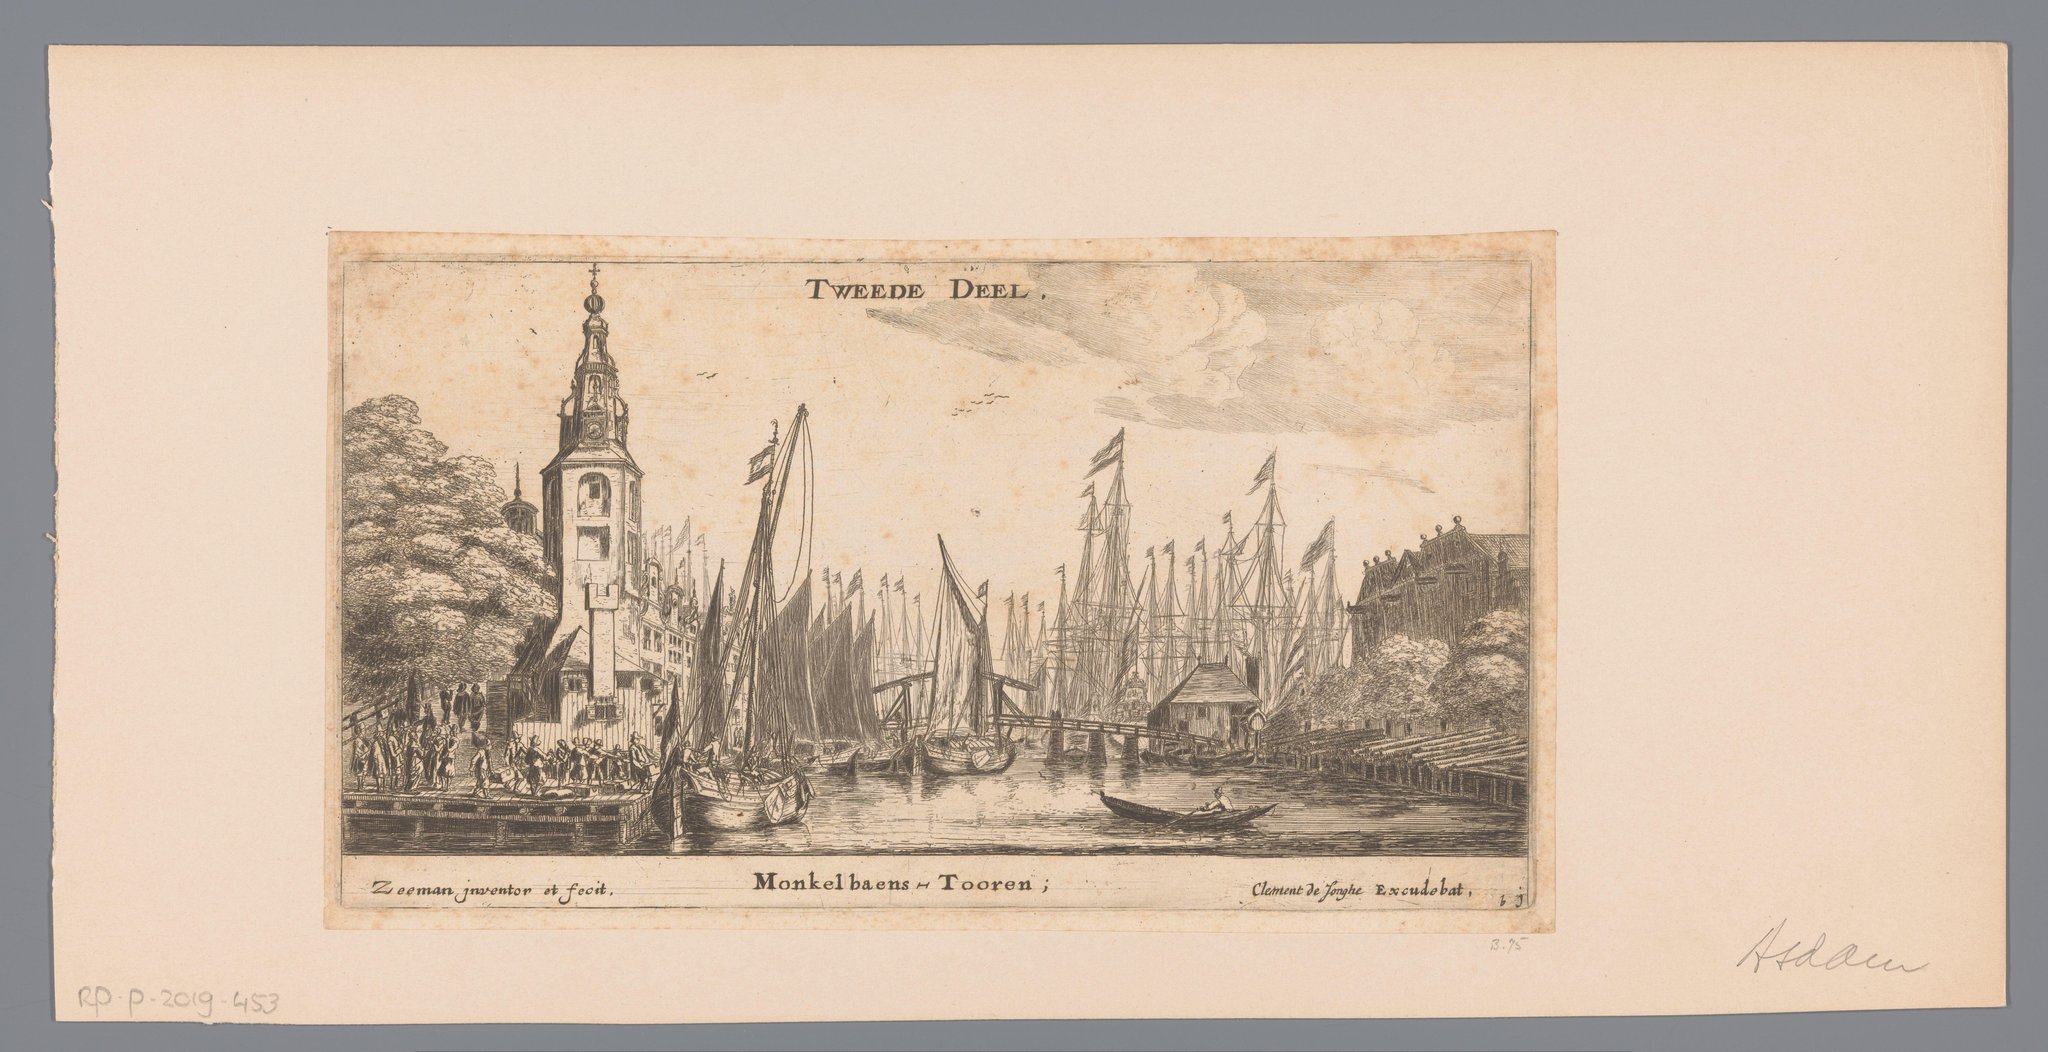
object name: print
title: Verscheyde Schepen en Gesichten van Amstelredam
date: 1652-1654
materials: paper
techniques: drypoint, etching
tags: sailing-ship, sailing-boat, towers ~ fortified city, rowing-boat, canoe, etc., bridge in city across river, canal, etc.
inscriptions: collector's mark: Lugt 1227, collector's mark: Lugt 2228, collector's mark: ‘A421’, annotation: ‘12 / cu’, collector's mark: Lugt 462, collector's mark: Lugt 1494